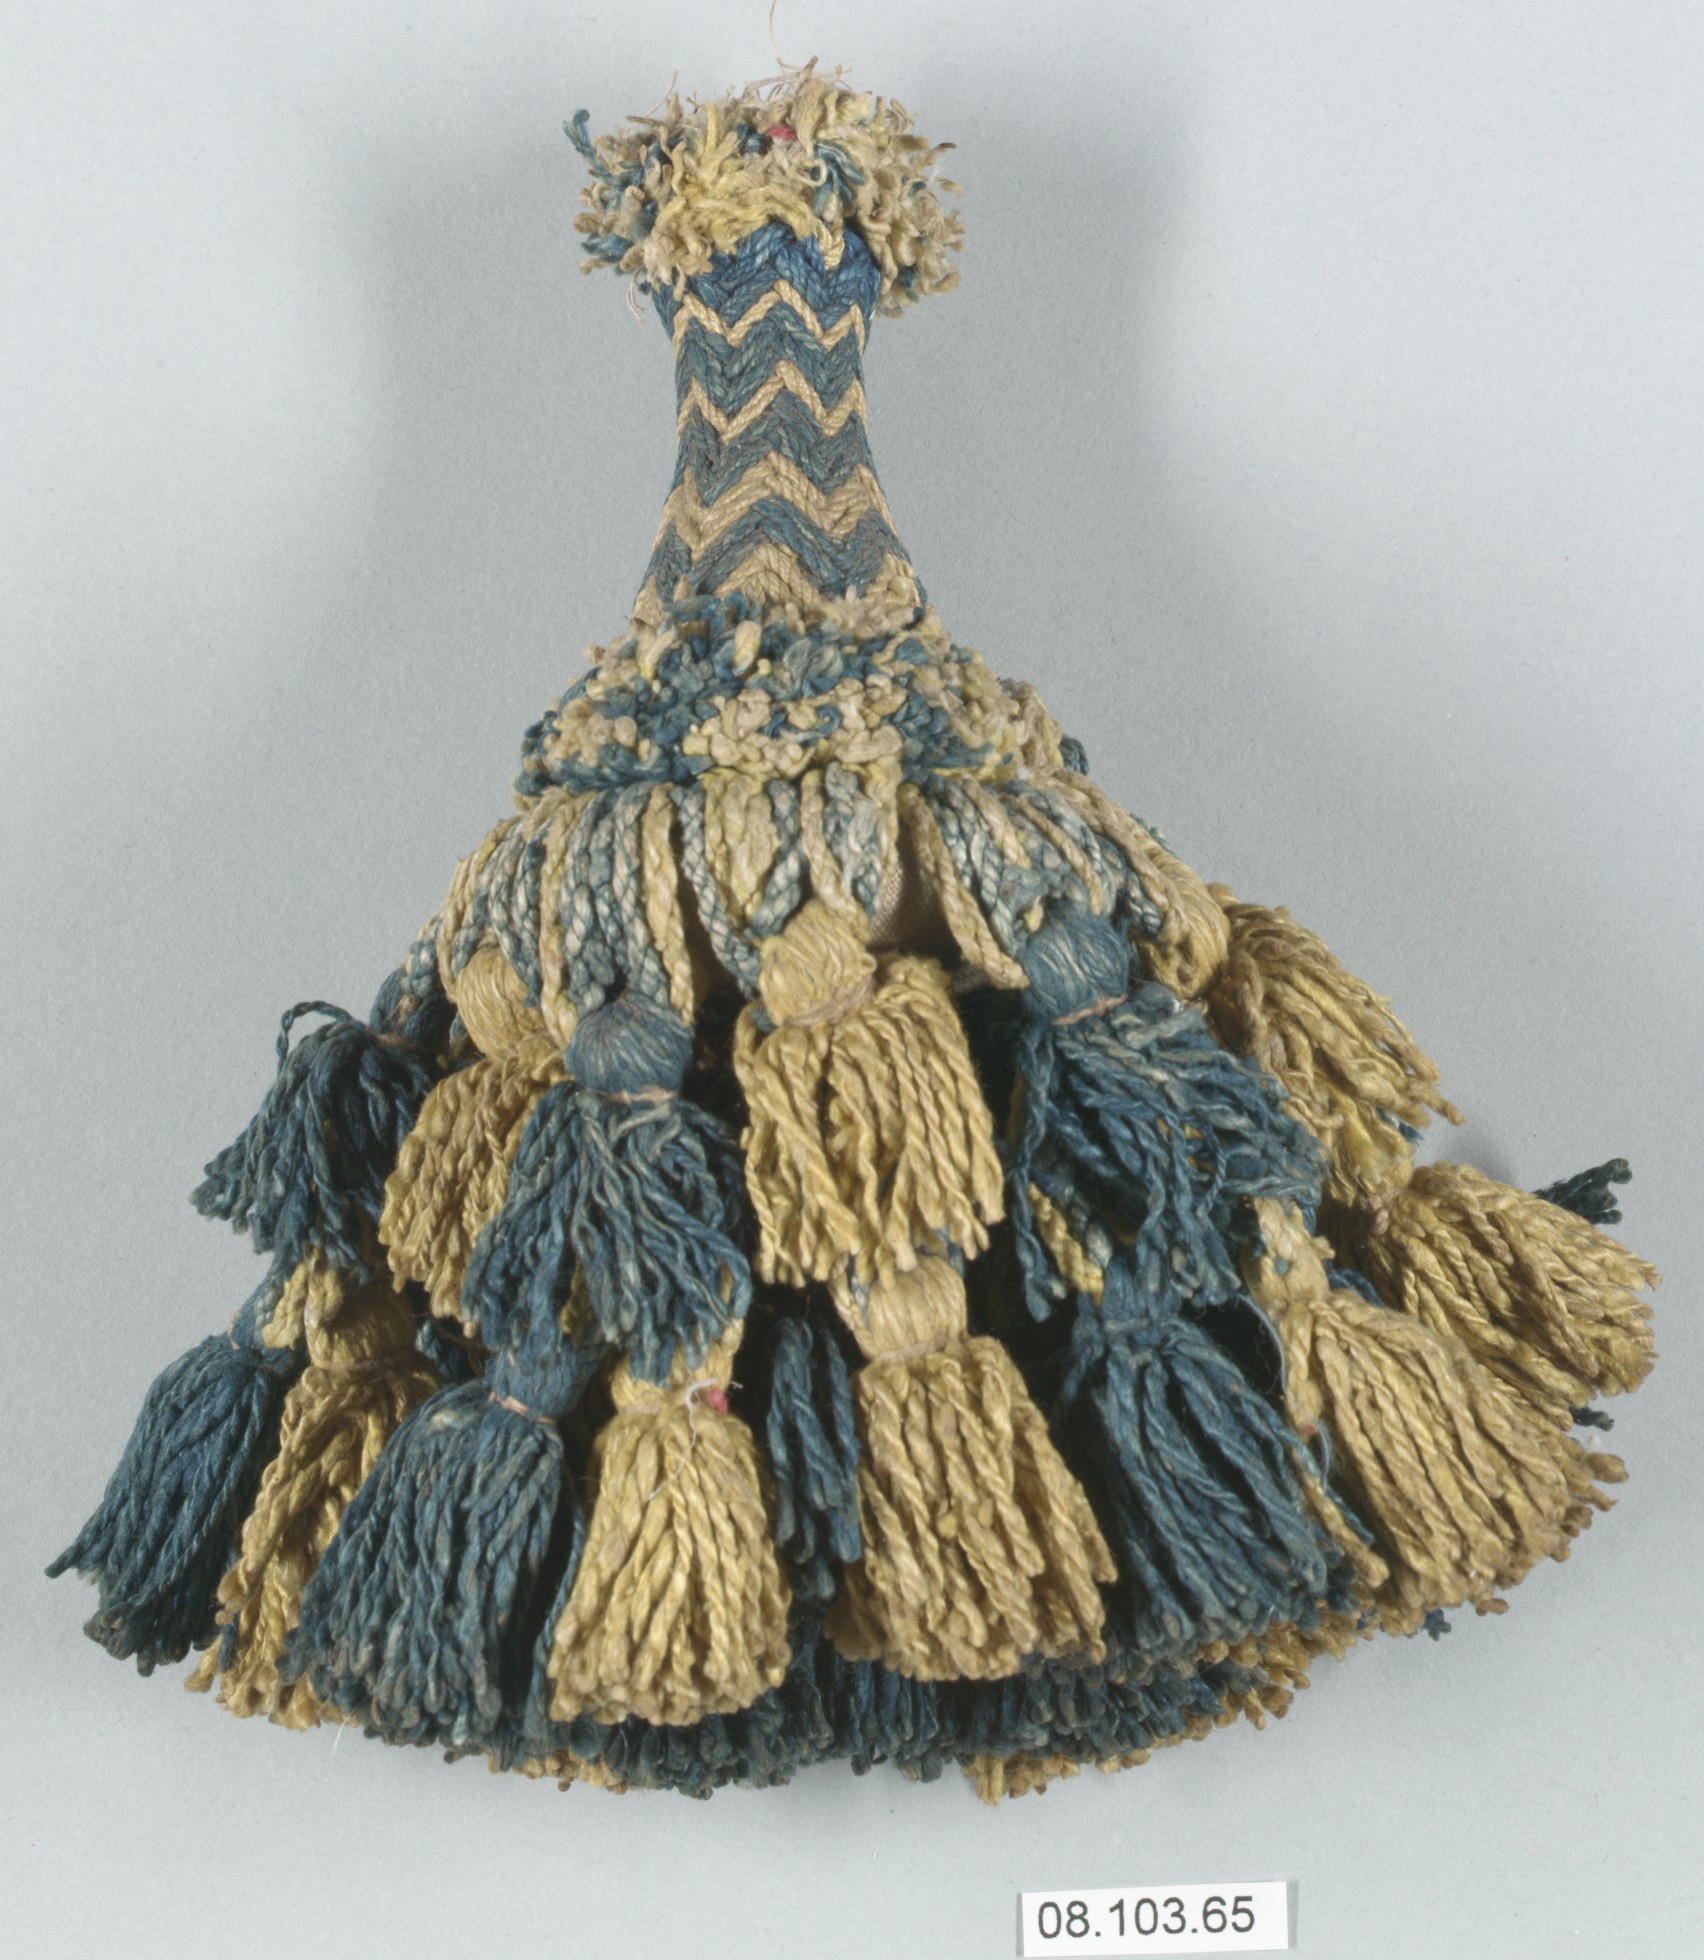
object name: tassel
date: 1501-1600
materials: cotton